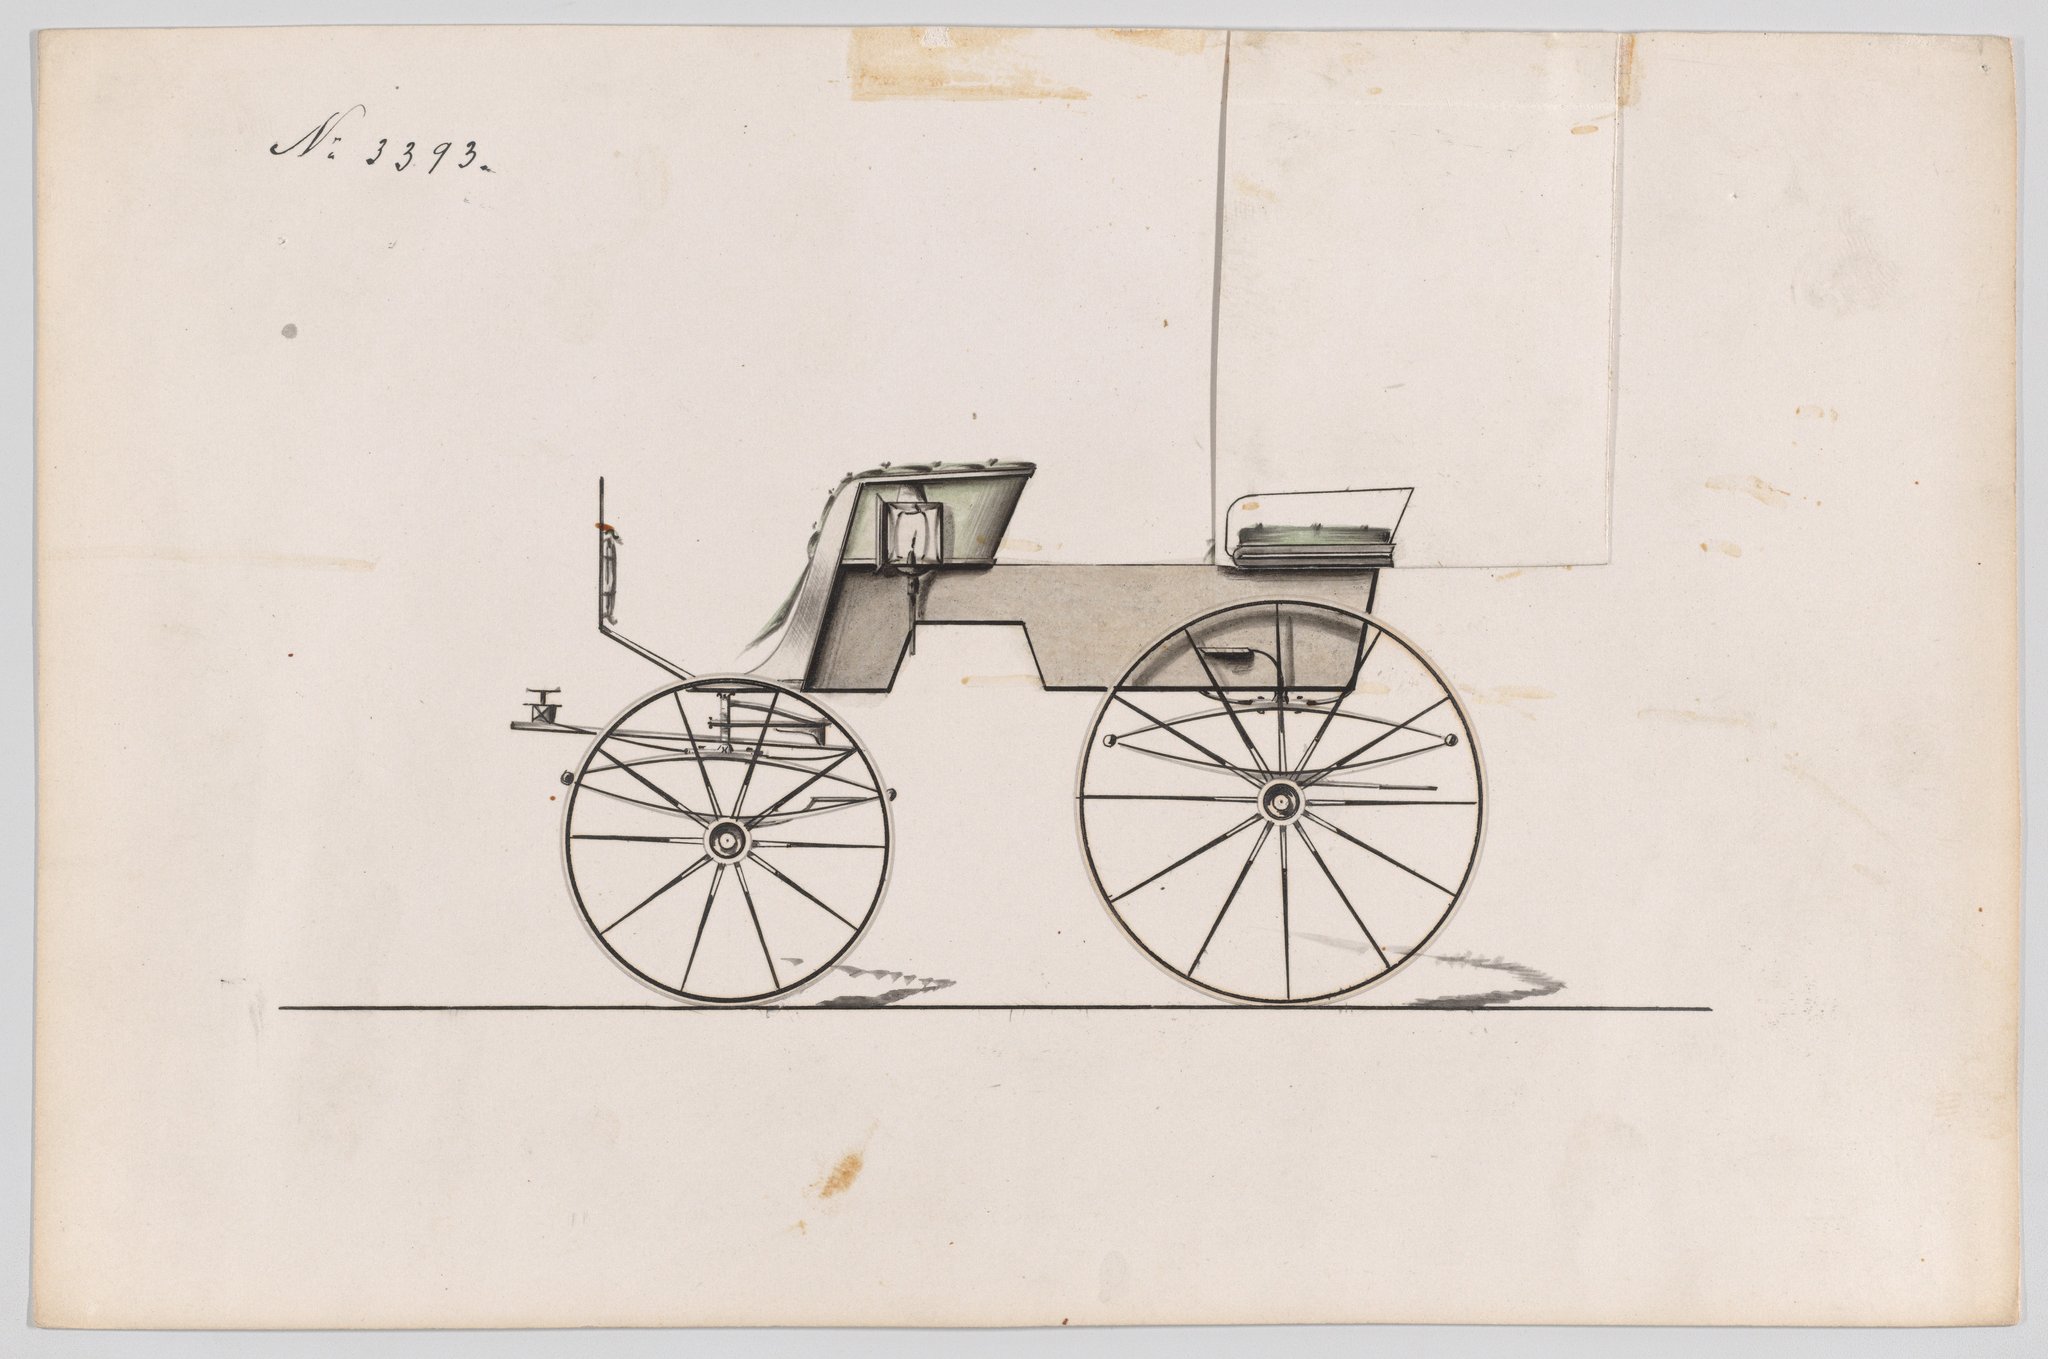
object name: drawing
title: Design for T-Cart, no. 3393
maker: brewster & co.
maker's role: manufacturer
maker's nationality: american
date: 1878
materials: gouache, gum arabic, ink, watercolor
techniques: pen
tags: carriages